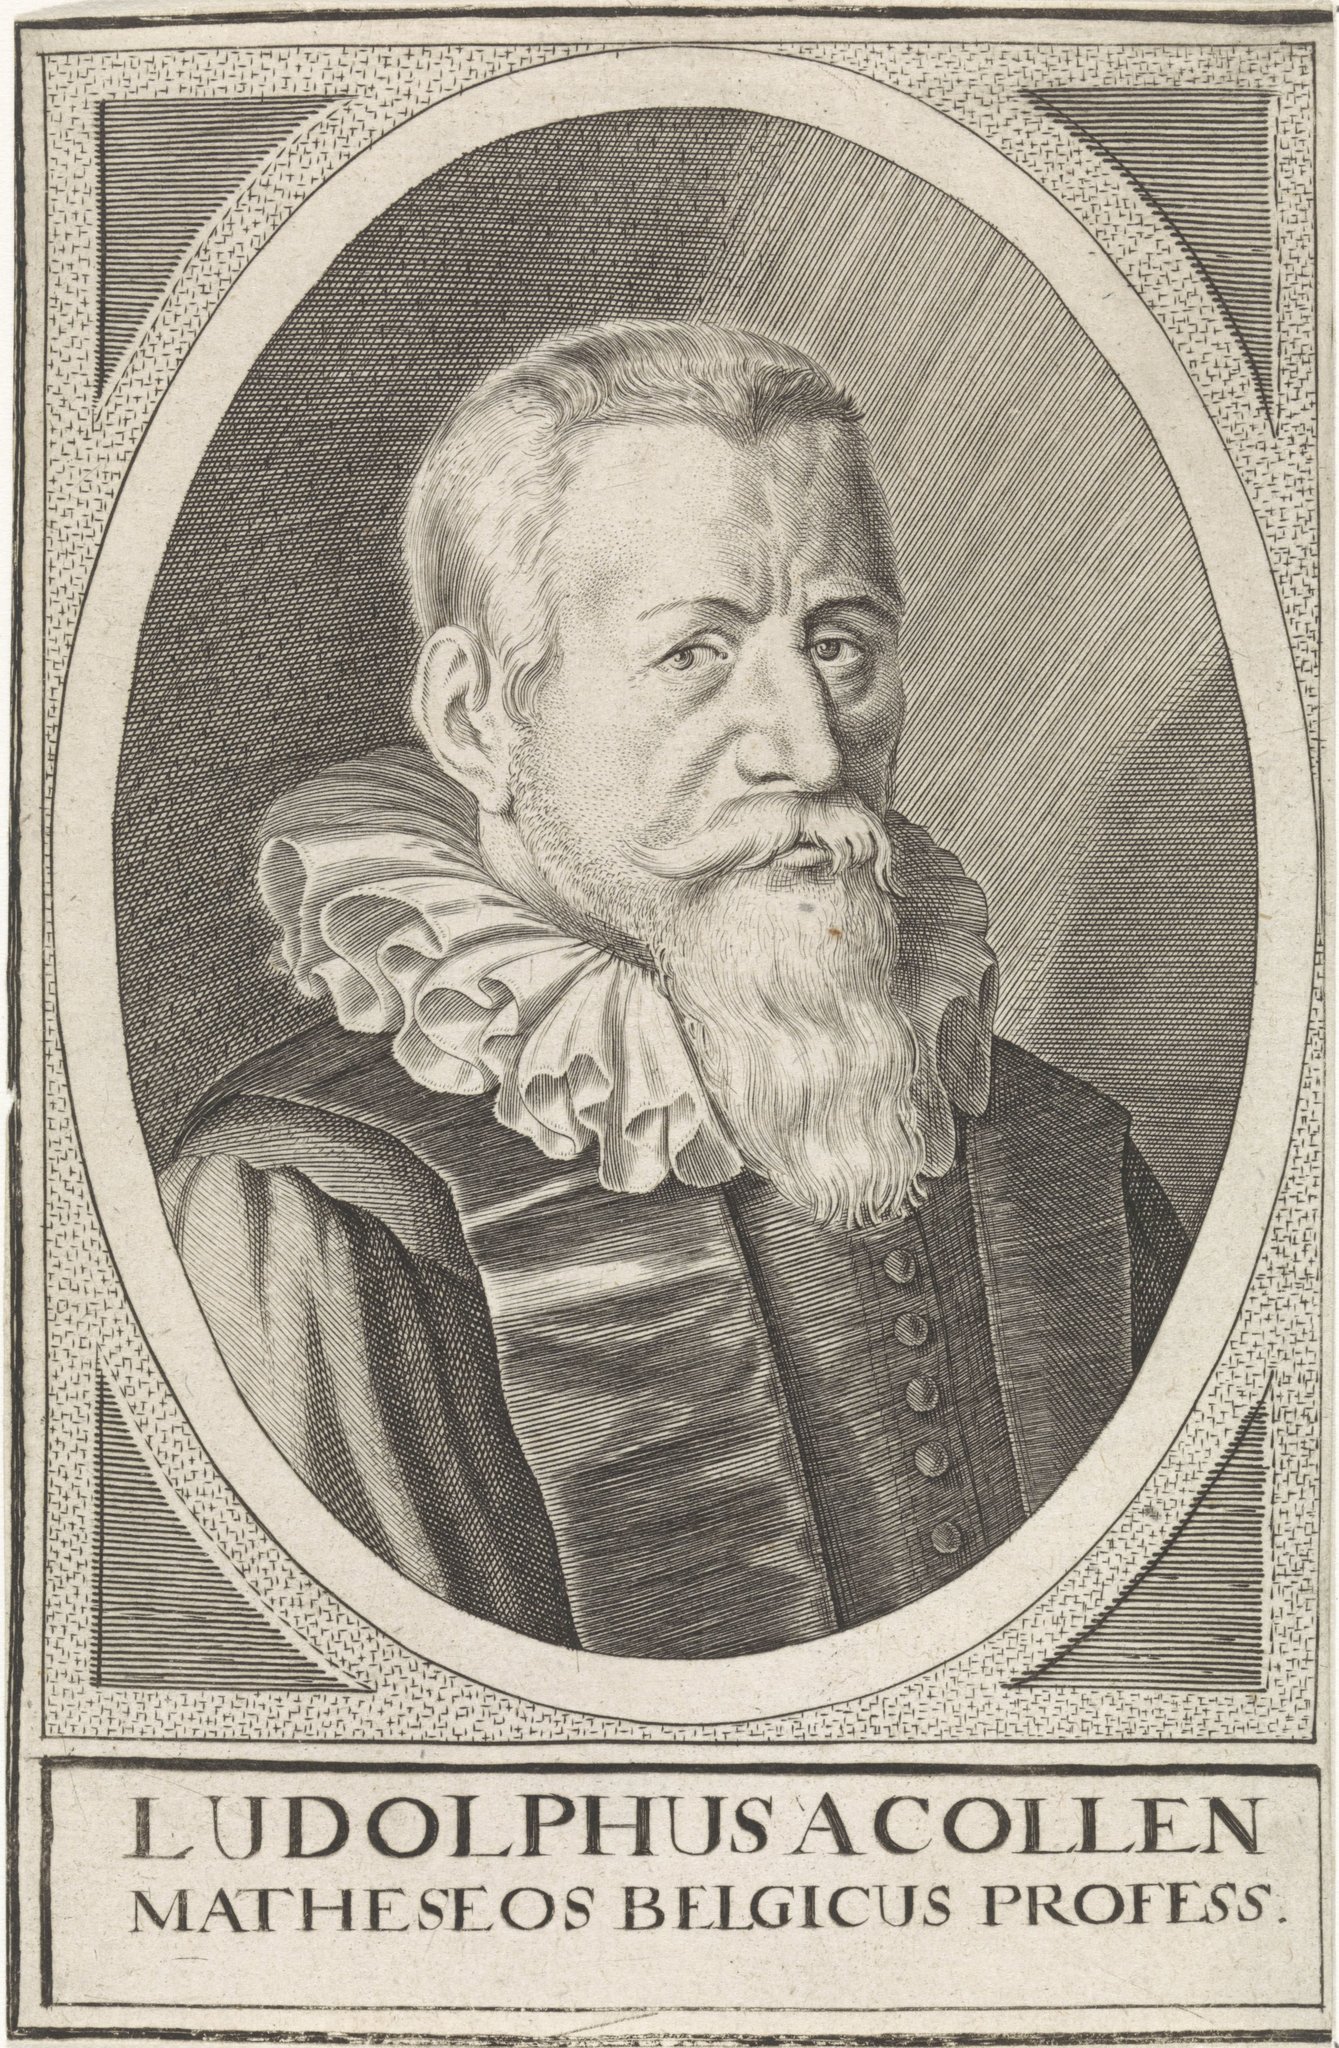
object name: print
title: Portret van Ludolph van Ceulen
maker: de passe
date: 1625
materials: paper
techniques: engraving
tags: leiden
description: Prent ook gebruikt als boekillustratie in: Meursius, Joannes. Athenæ Batavæ. Sive, De vrbe Leidensi, & academiâ, virisque claris. Leiden: Andries Clouck, Bonaventura en Abraham Elzevier, 1625.